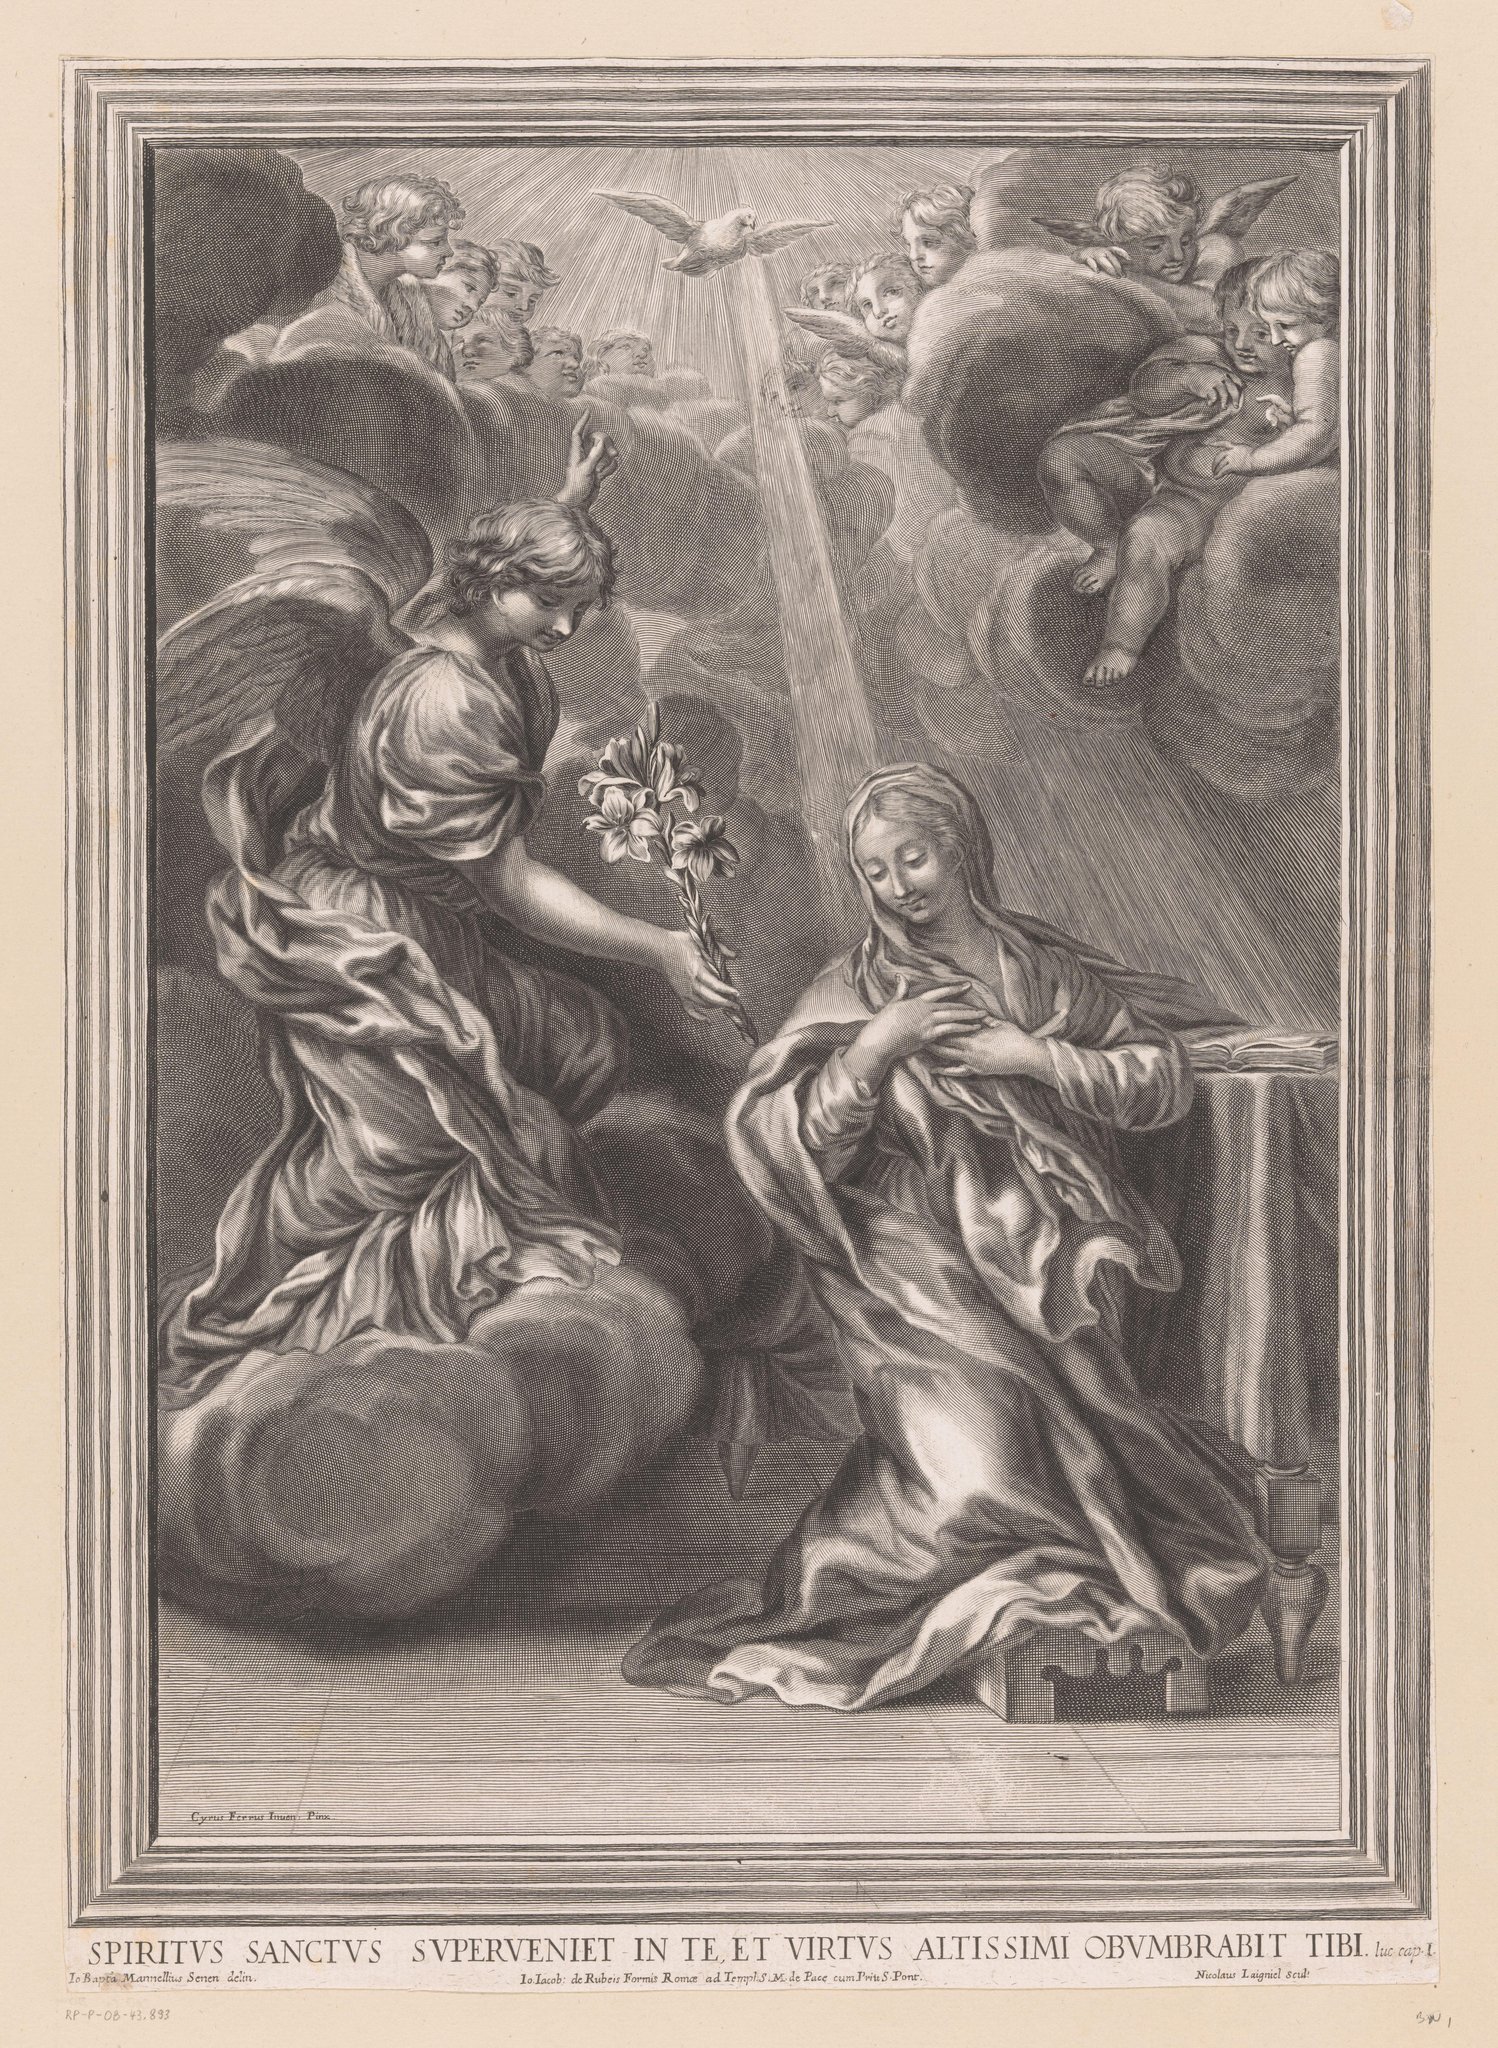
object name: print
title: Annunciatie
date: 1670-1691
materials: paper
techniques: engraving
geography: france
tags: the annunciation: mary, usually reading, is visited by the angel (sometimes a woman overhears the conversation)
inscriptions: collector's mark: Lugt 240